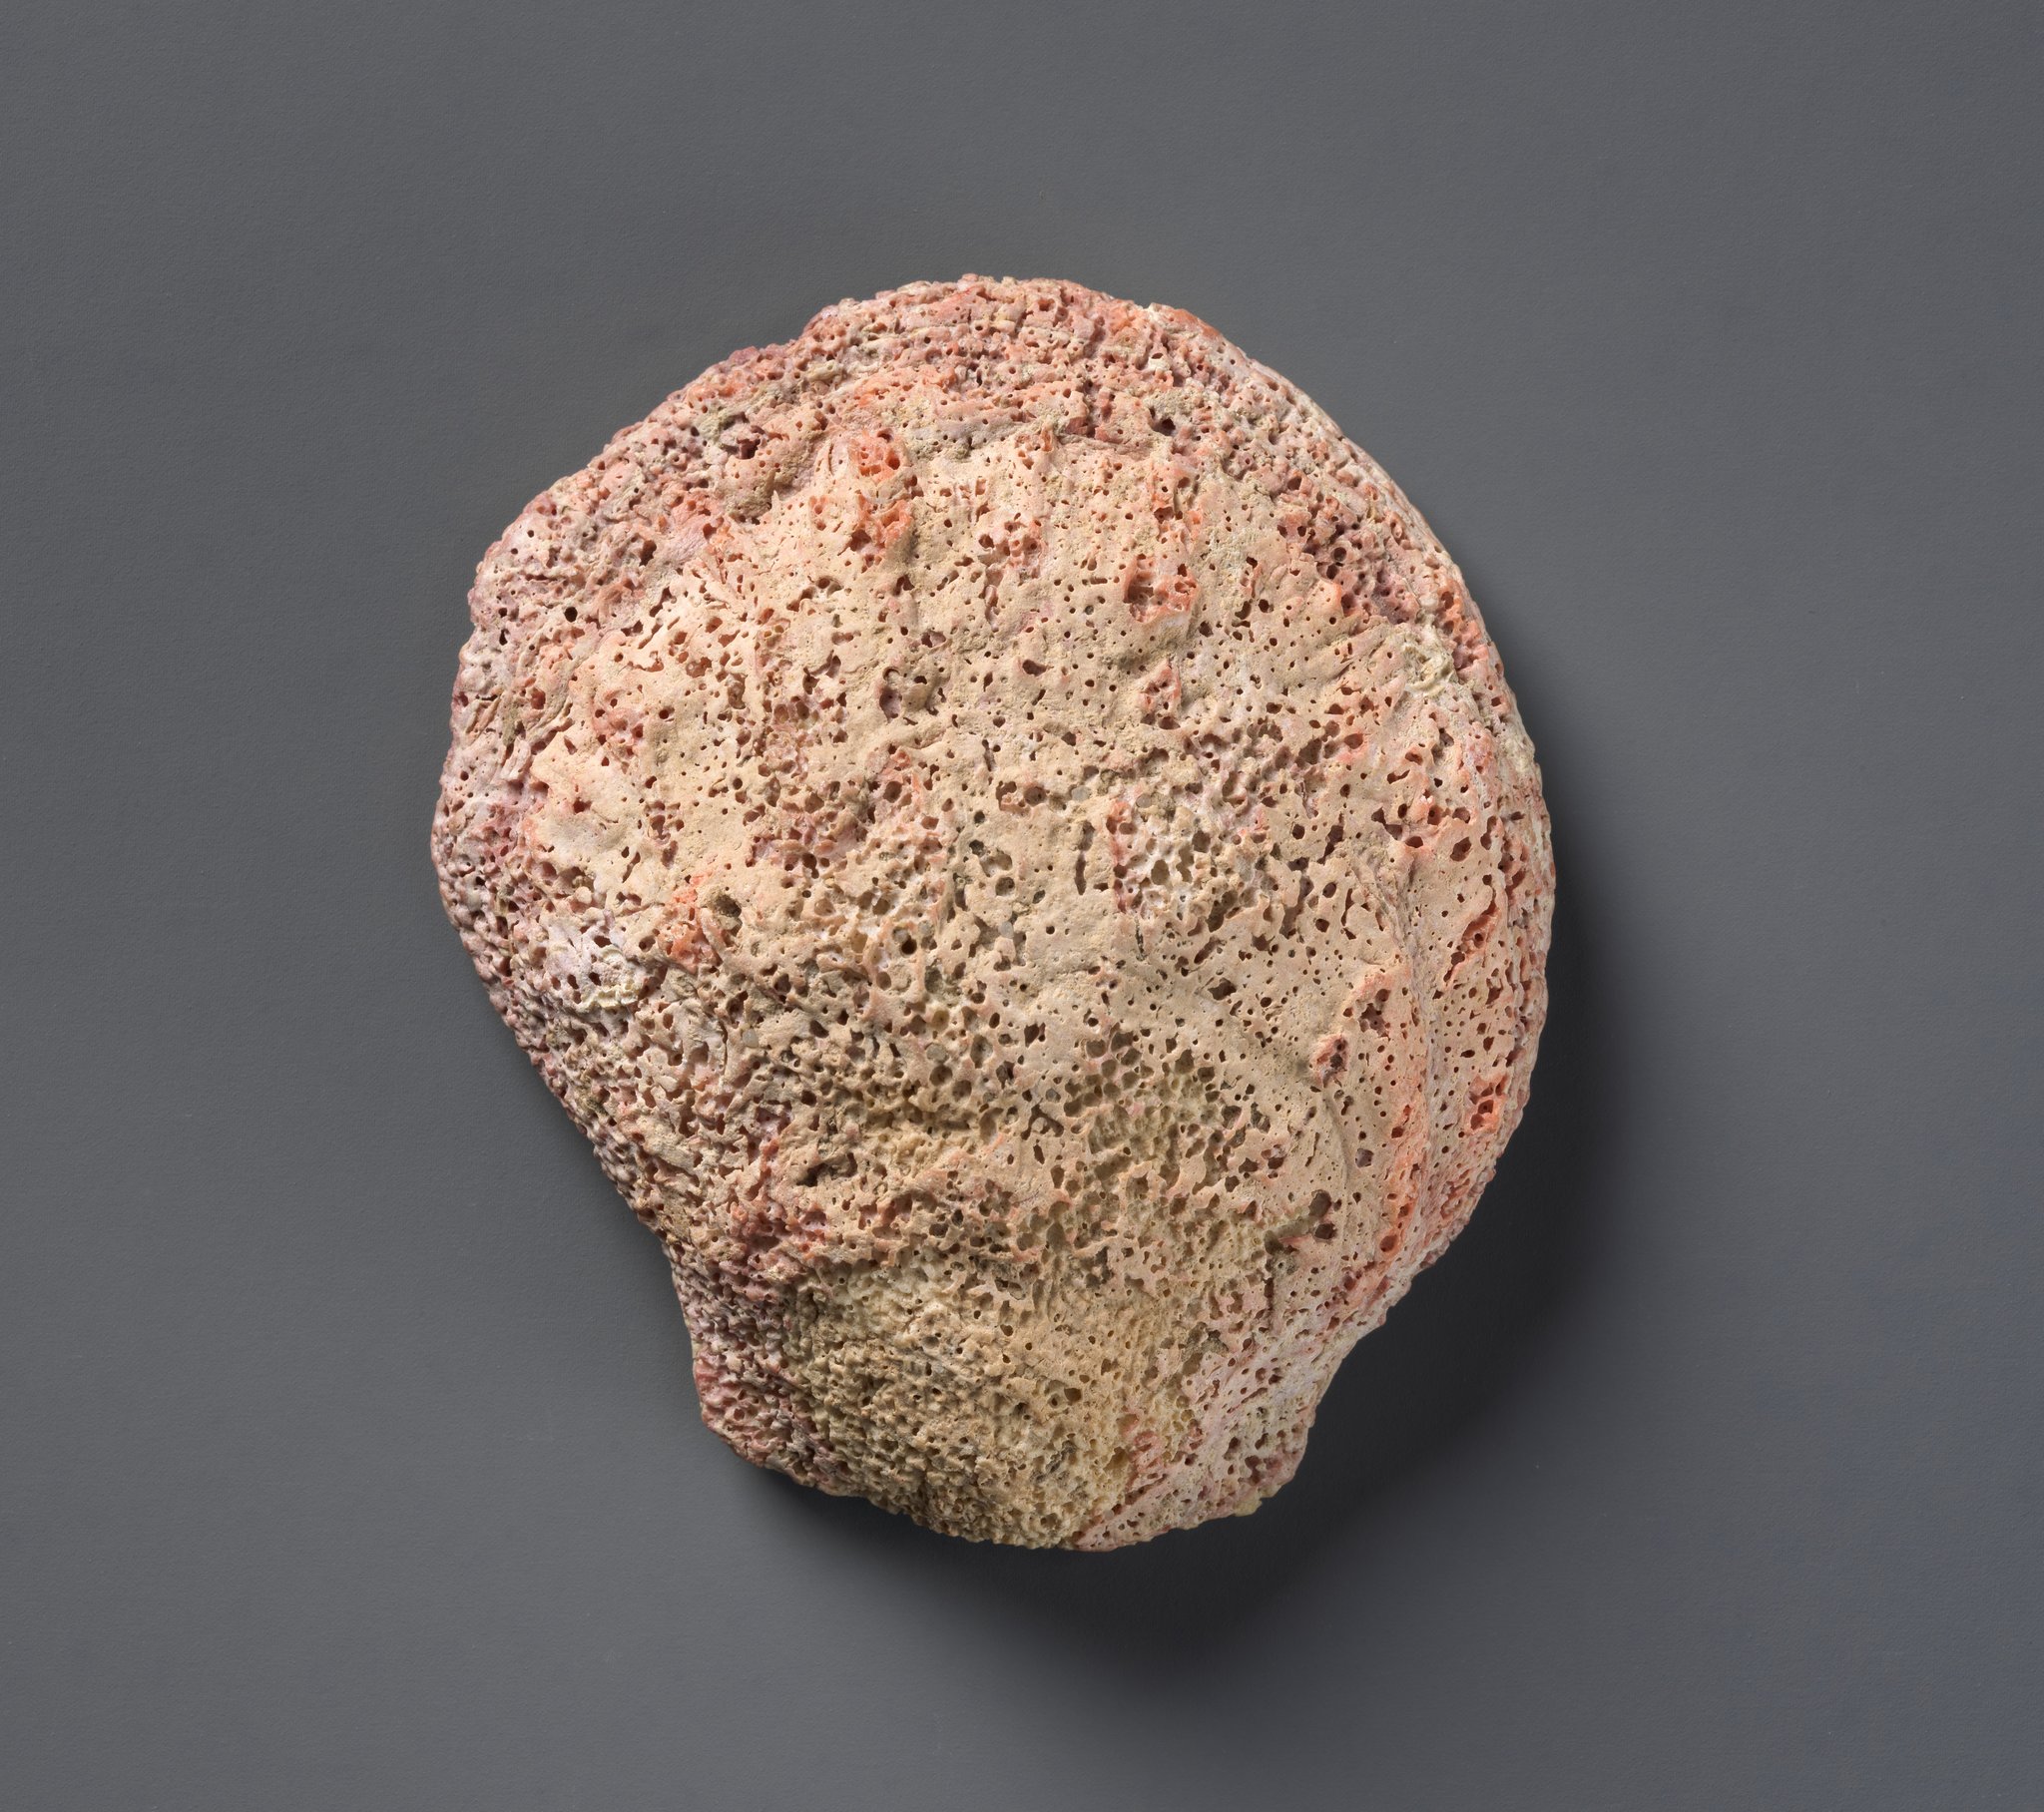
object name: shell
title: Scallop shell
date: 2600-2500 BCE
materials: shell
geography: mesopotamia